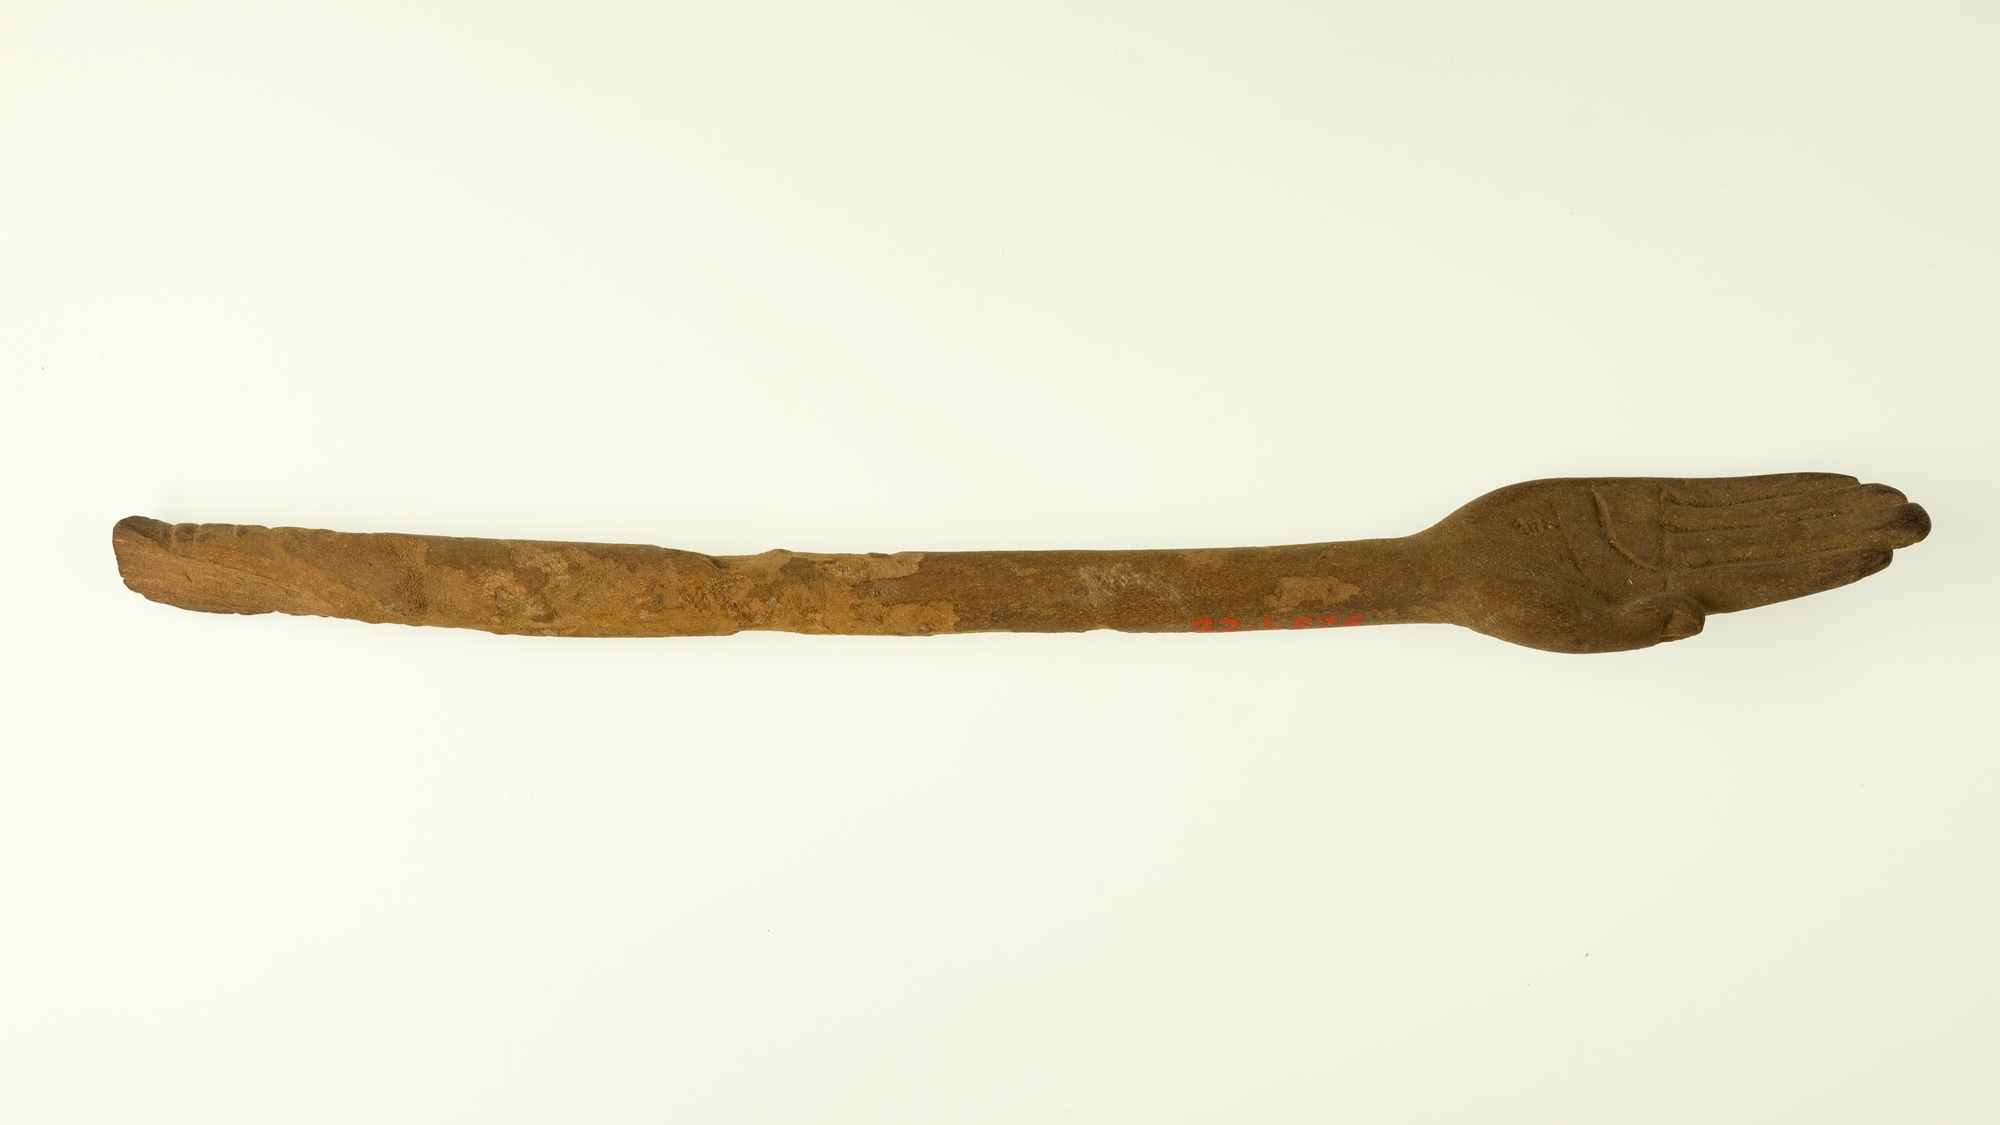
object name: spoon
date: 1186-1070 BCE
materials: wood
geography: egypt